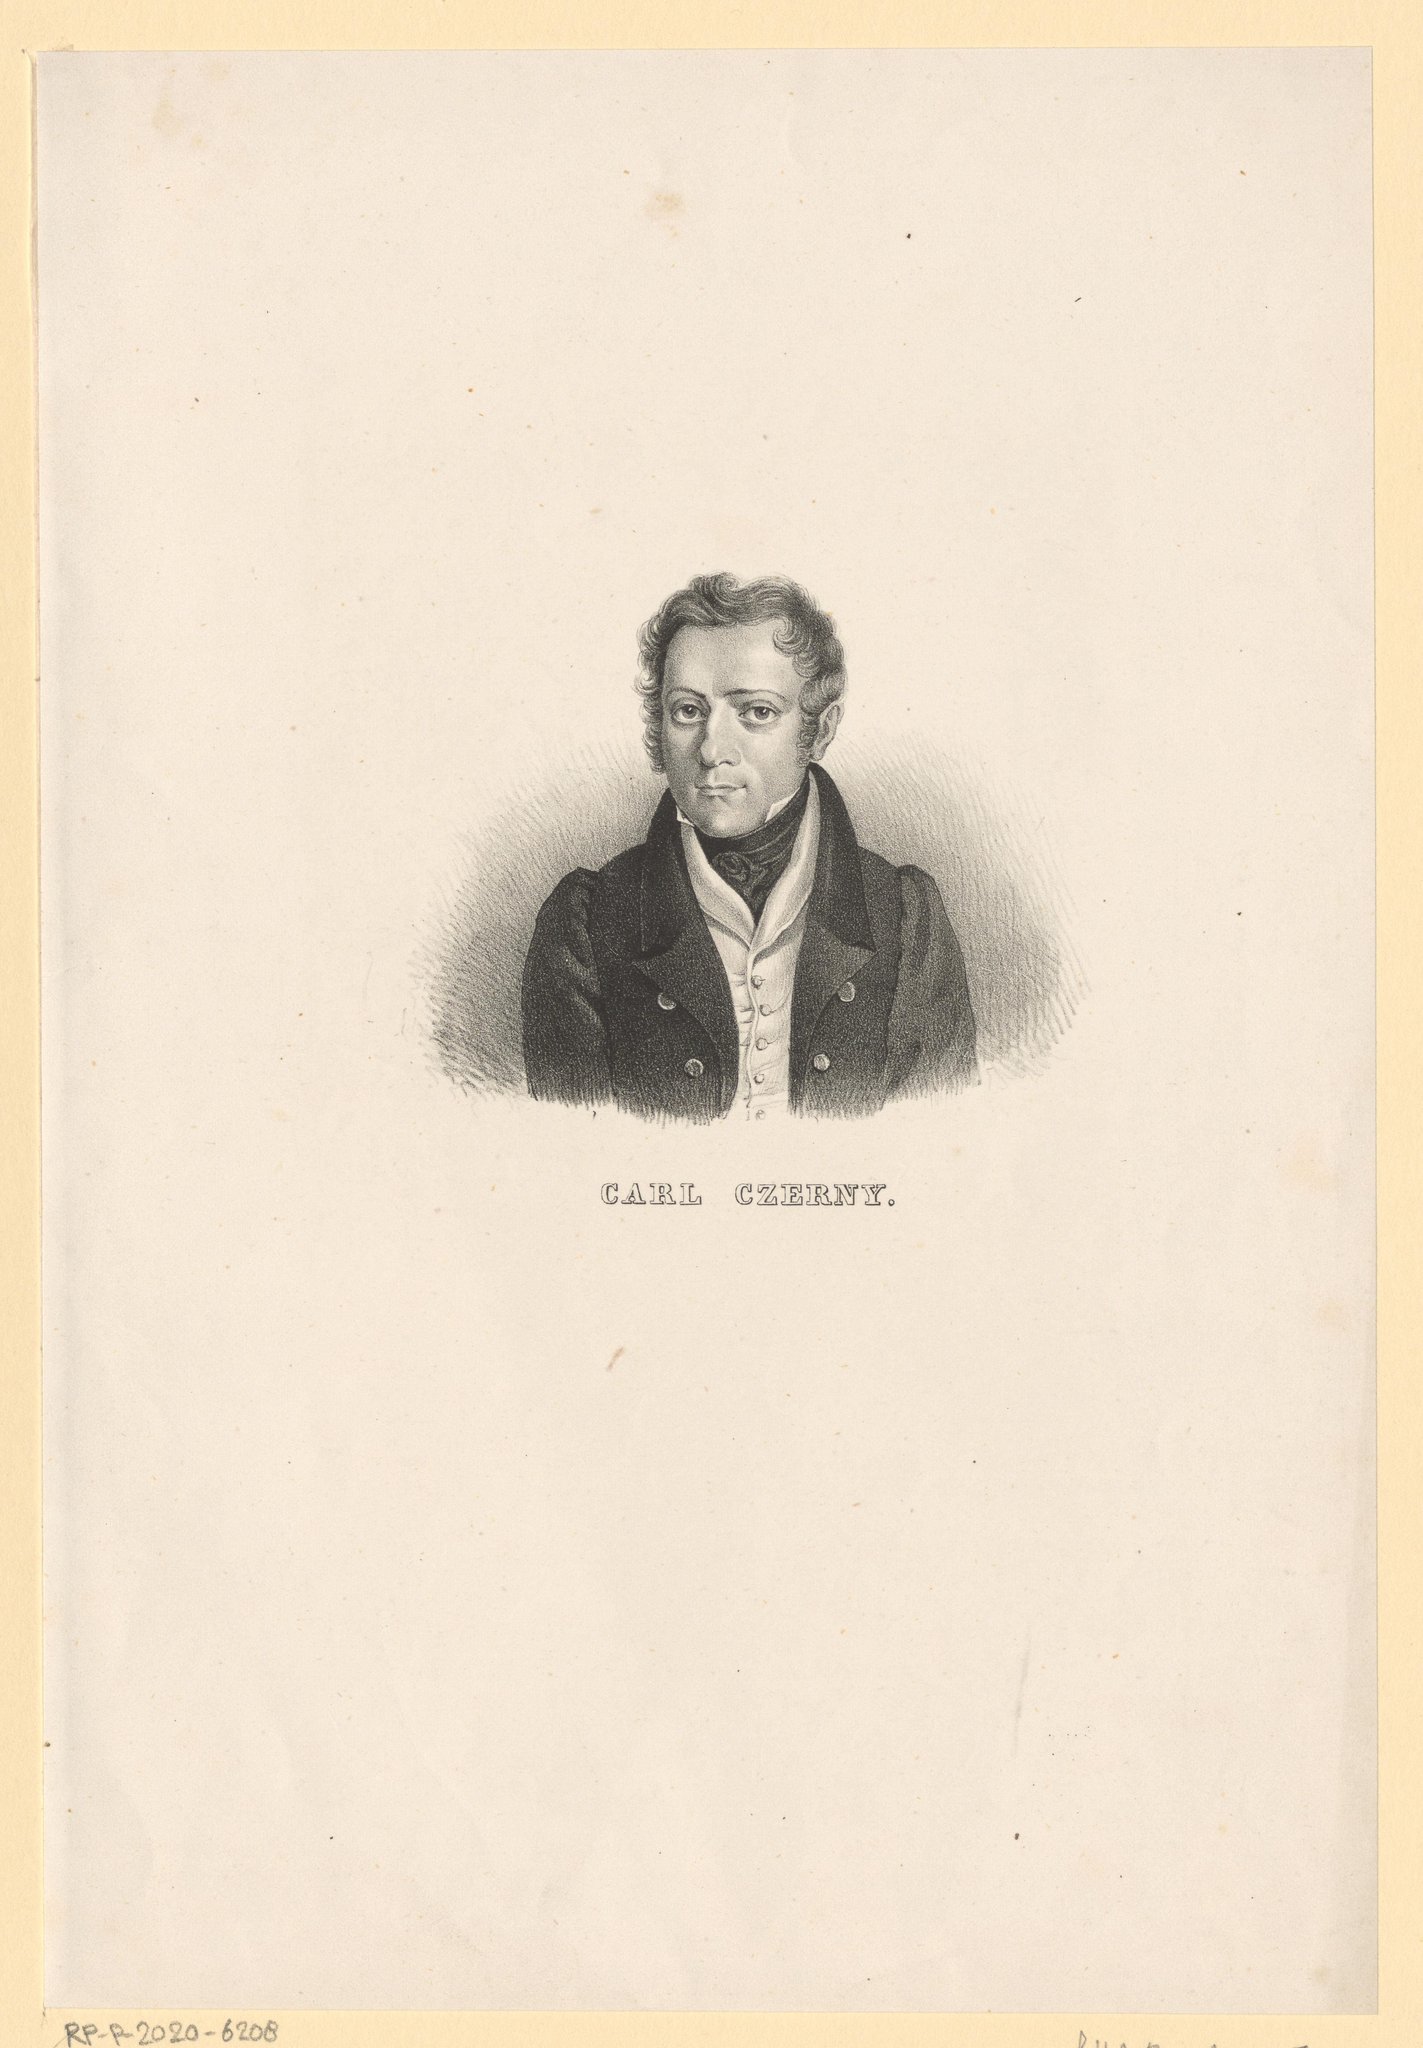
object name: print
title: Portret van Carl Czerny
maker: Anonymous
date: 1821-1899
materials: paper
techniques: lithograph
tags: vienna, historical persons